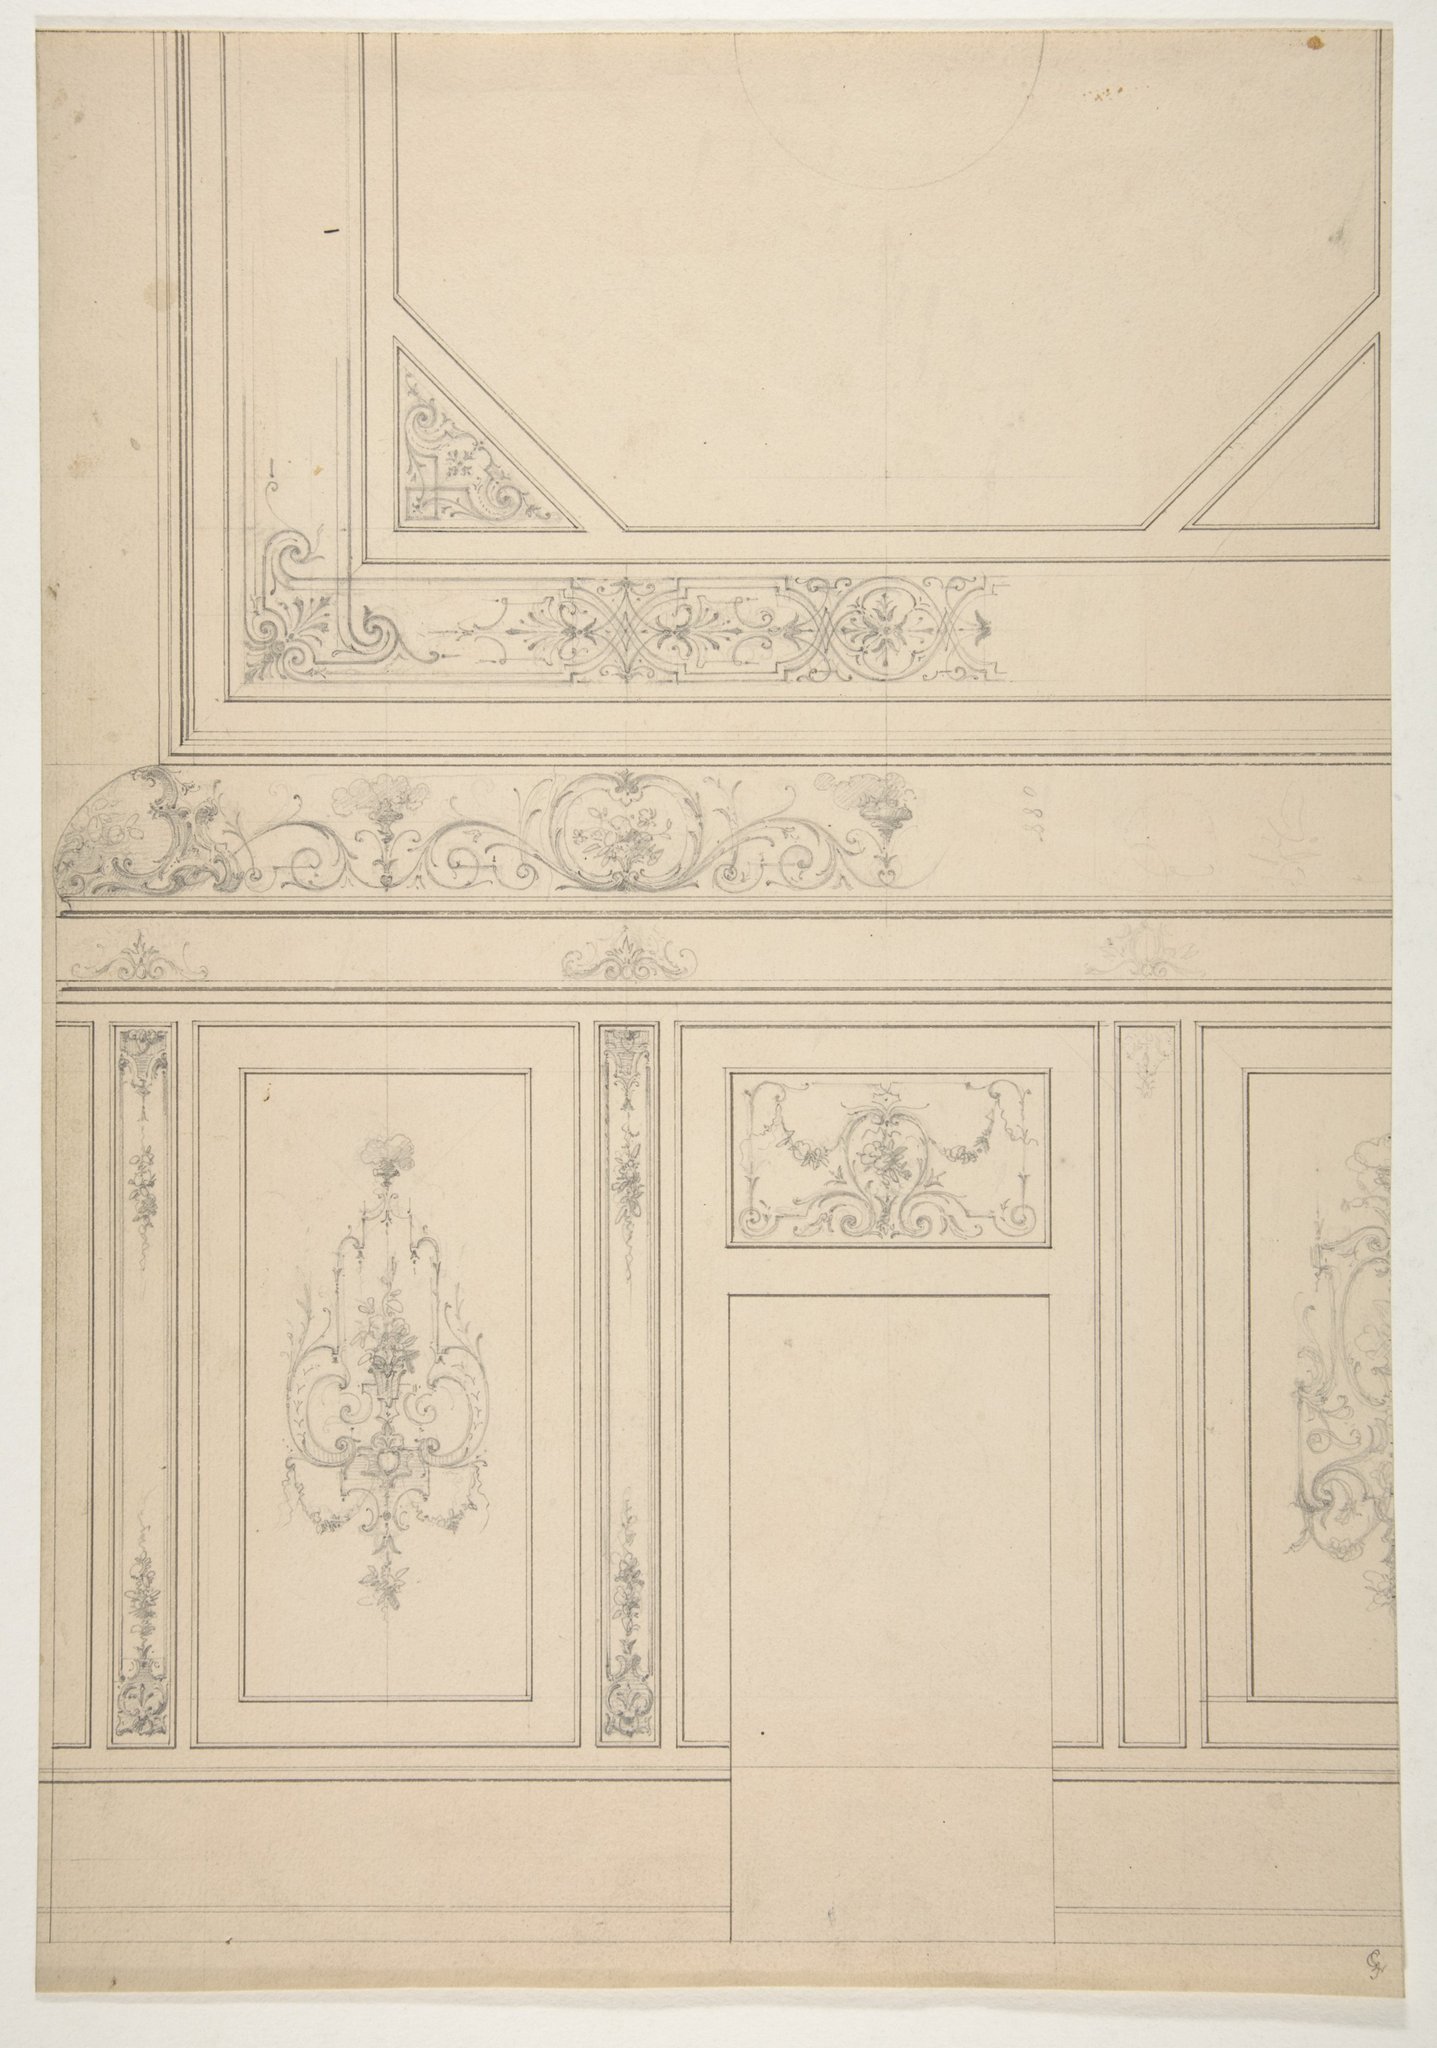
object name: drawing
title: Design for the painted decoration of a rooms walls and ceiling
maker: jules-edmond-charles lachaise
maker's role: artist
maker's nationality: french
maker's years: 1897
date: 1830-1897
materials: graphite, ink, paper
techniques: pen